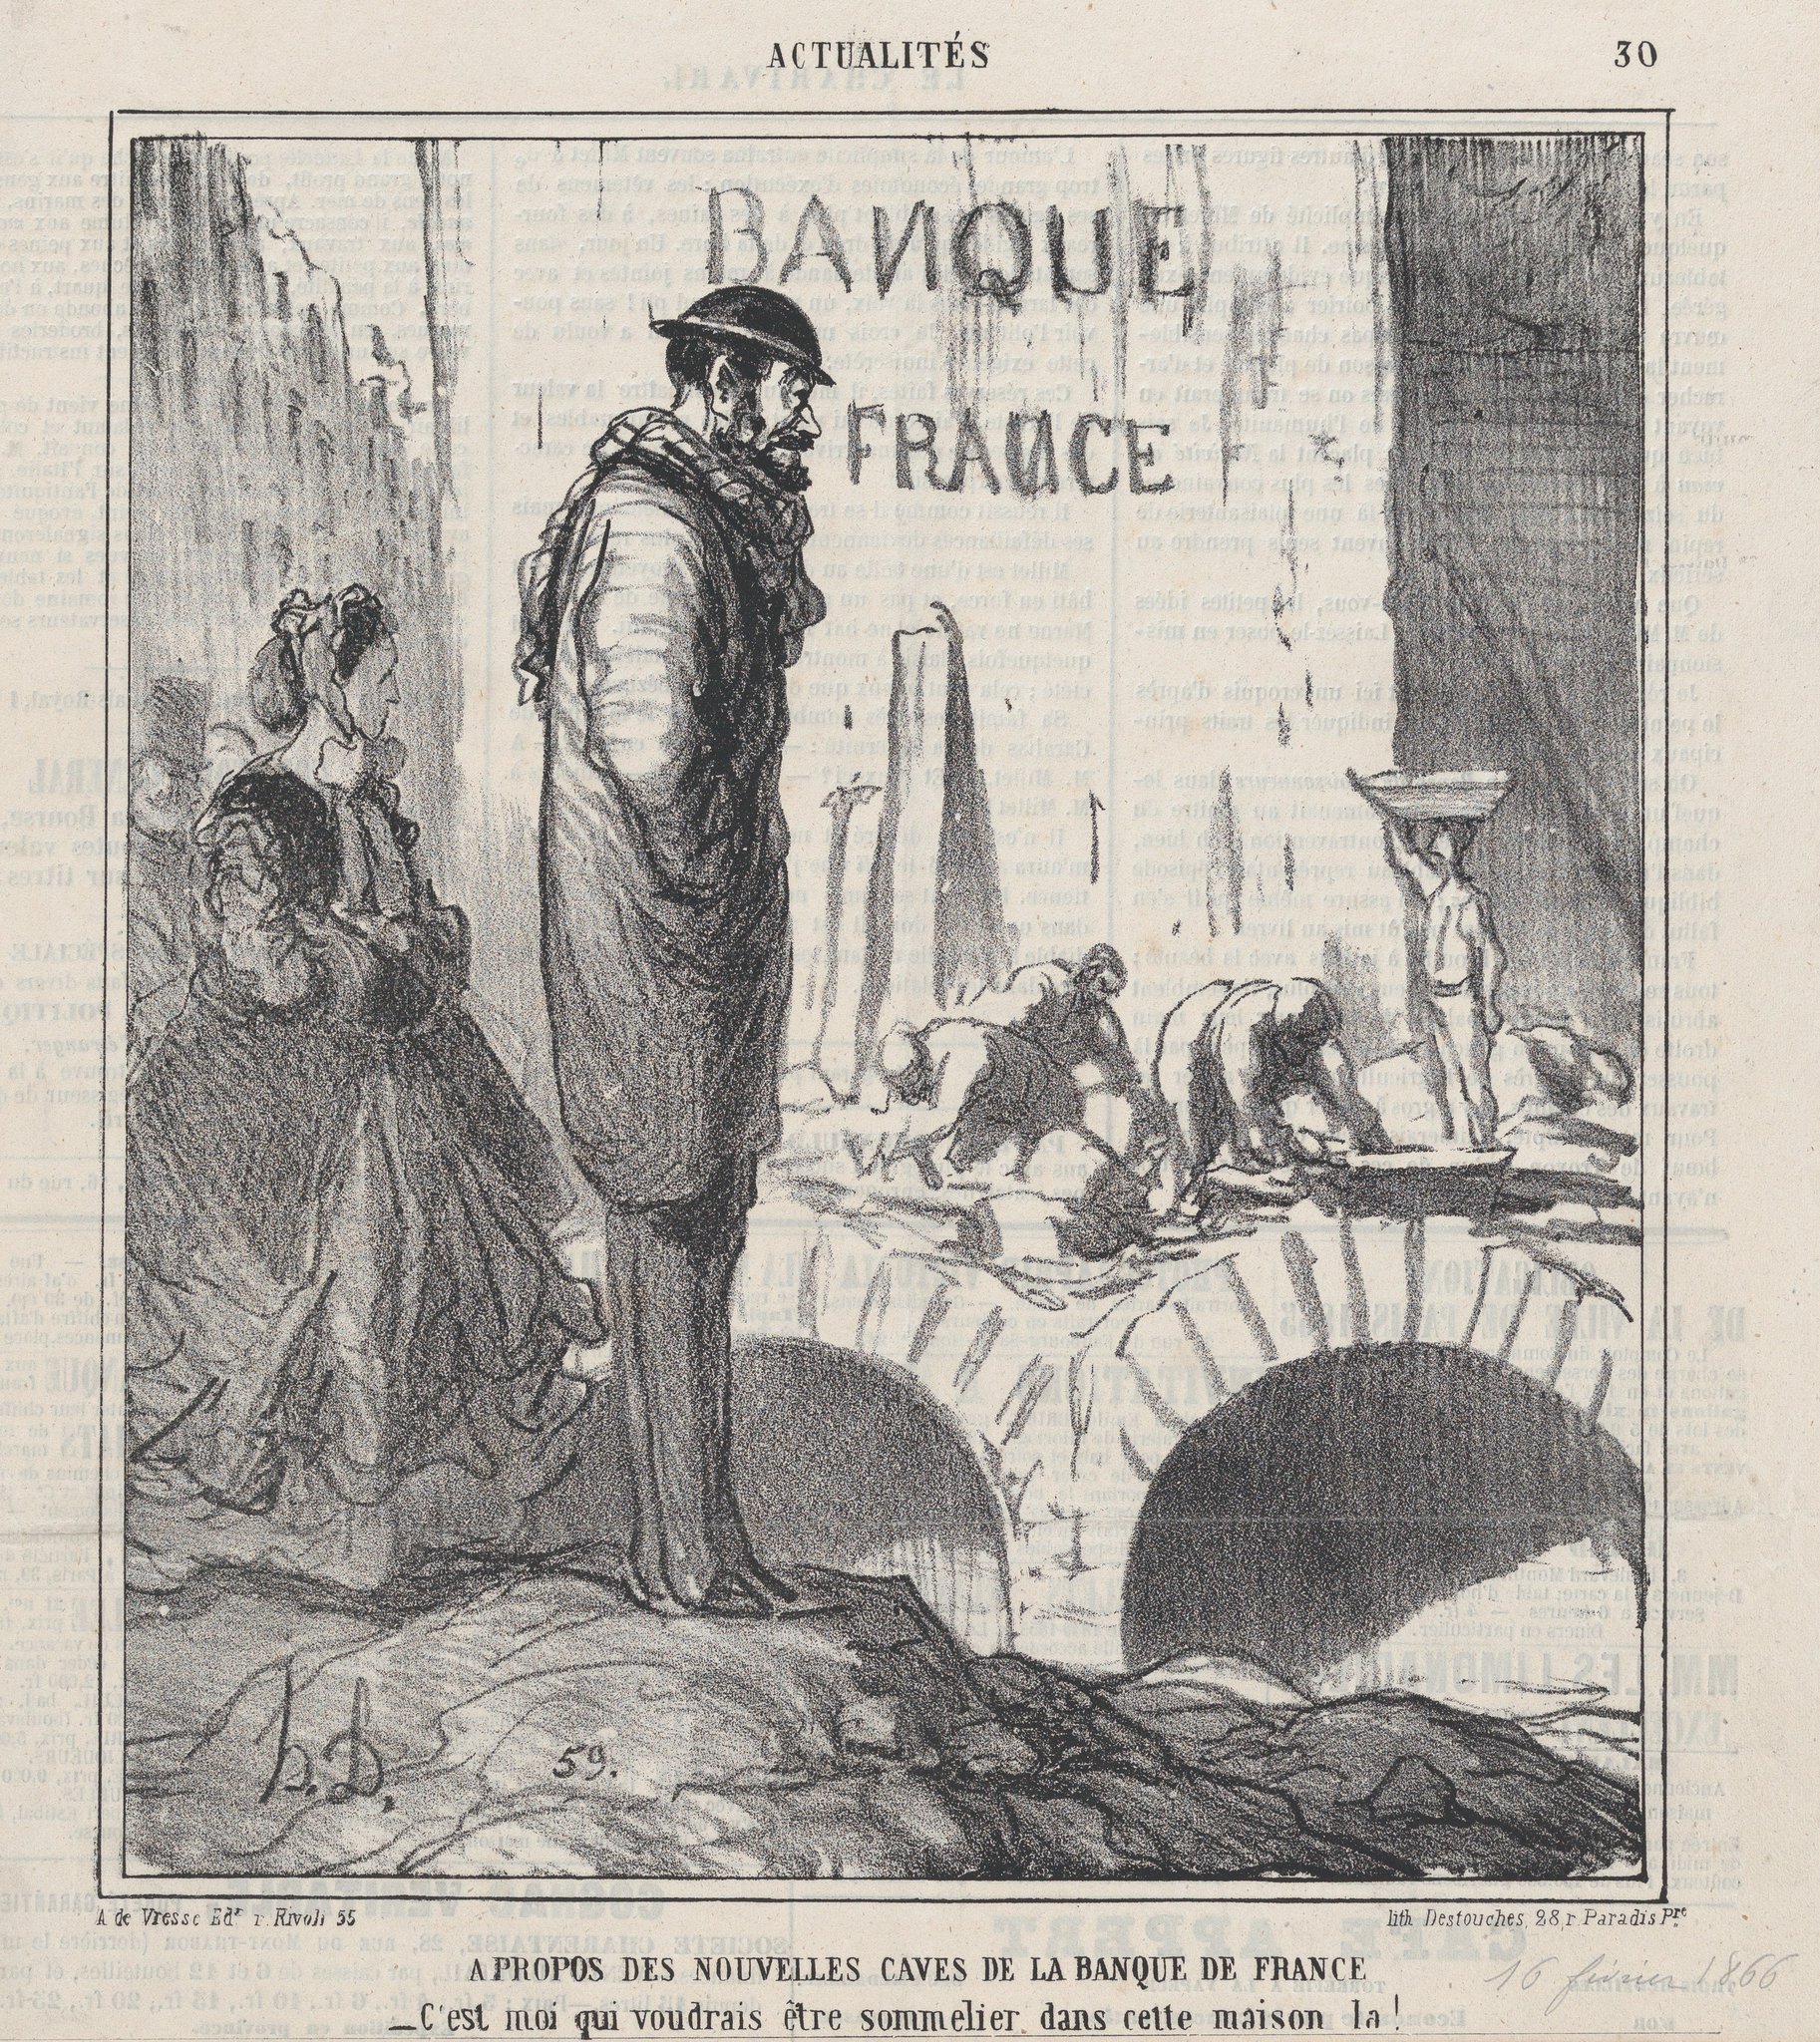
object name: print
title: About the Bank of France's new cellars: I wouldn't mind being the sommelier in that house!, from 'News of the day,' published in Le Charivari, February 16, 1866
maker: honoré daumier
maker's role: artist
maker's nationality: french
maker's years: 1808-1879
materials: paper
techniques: lithograph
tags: men,women,working